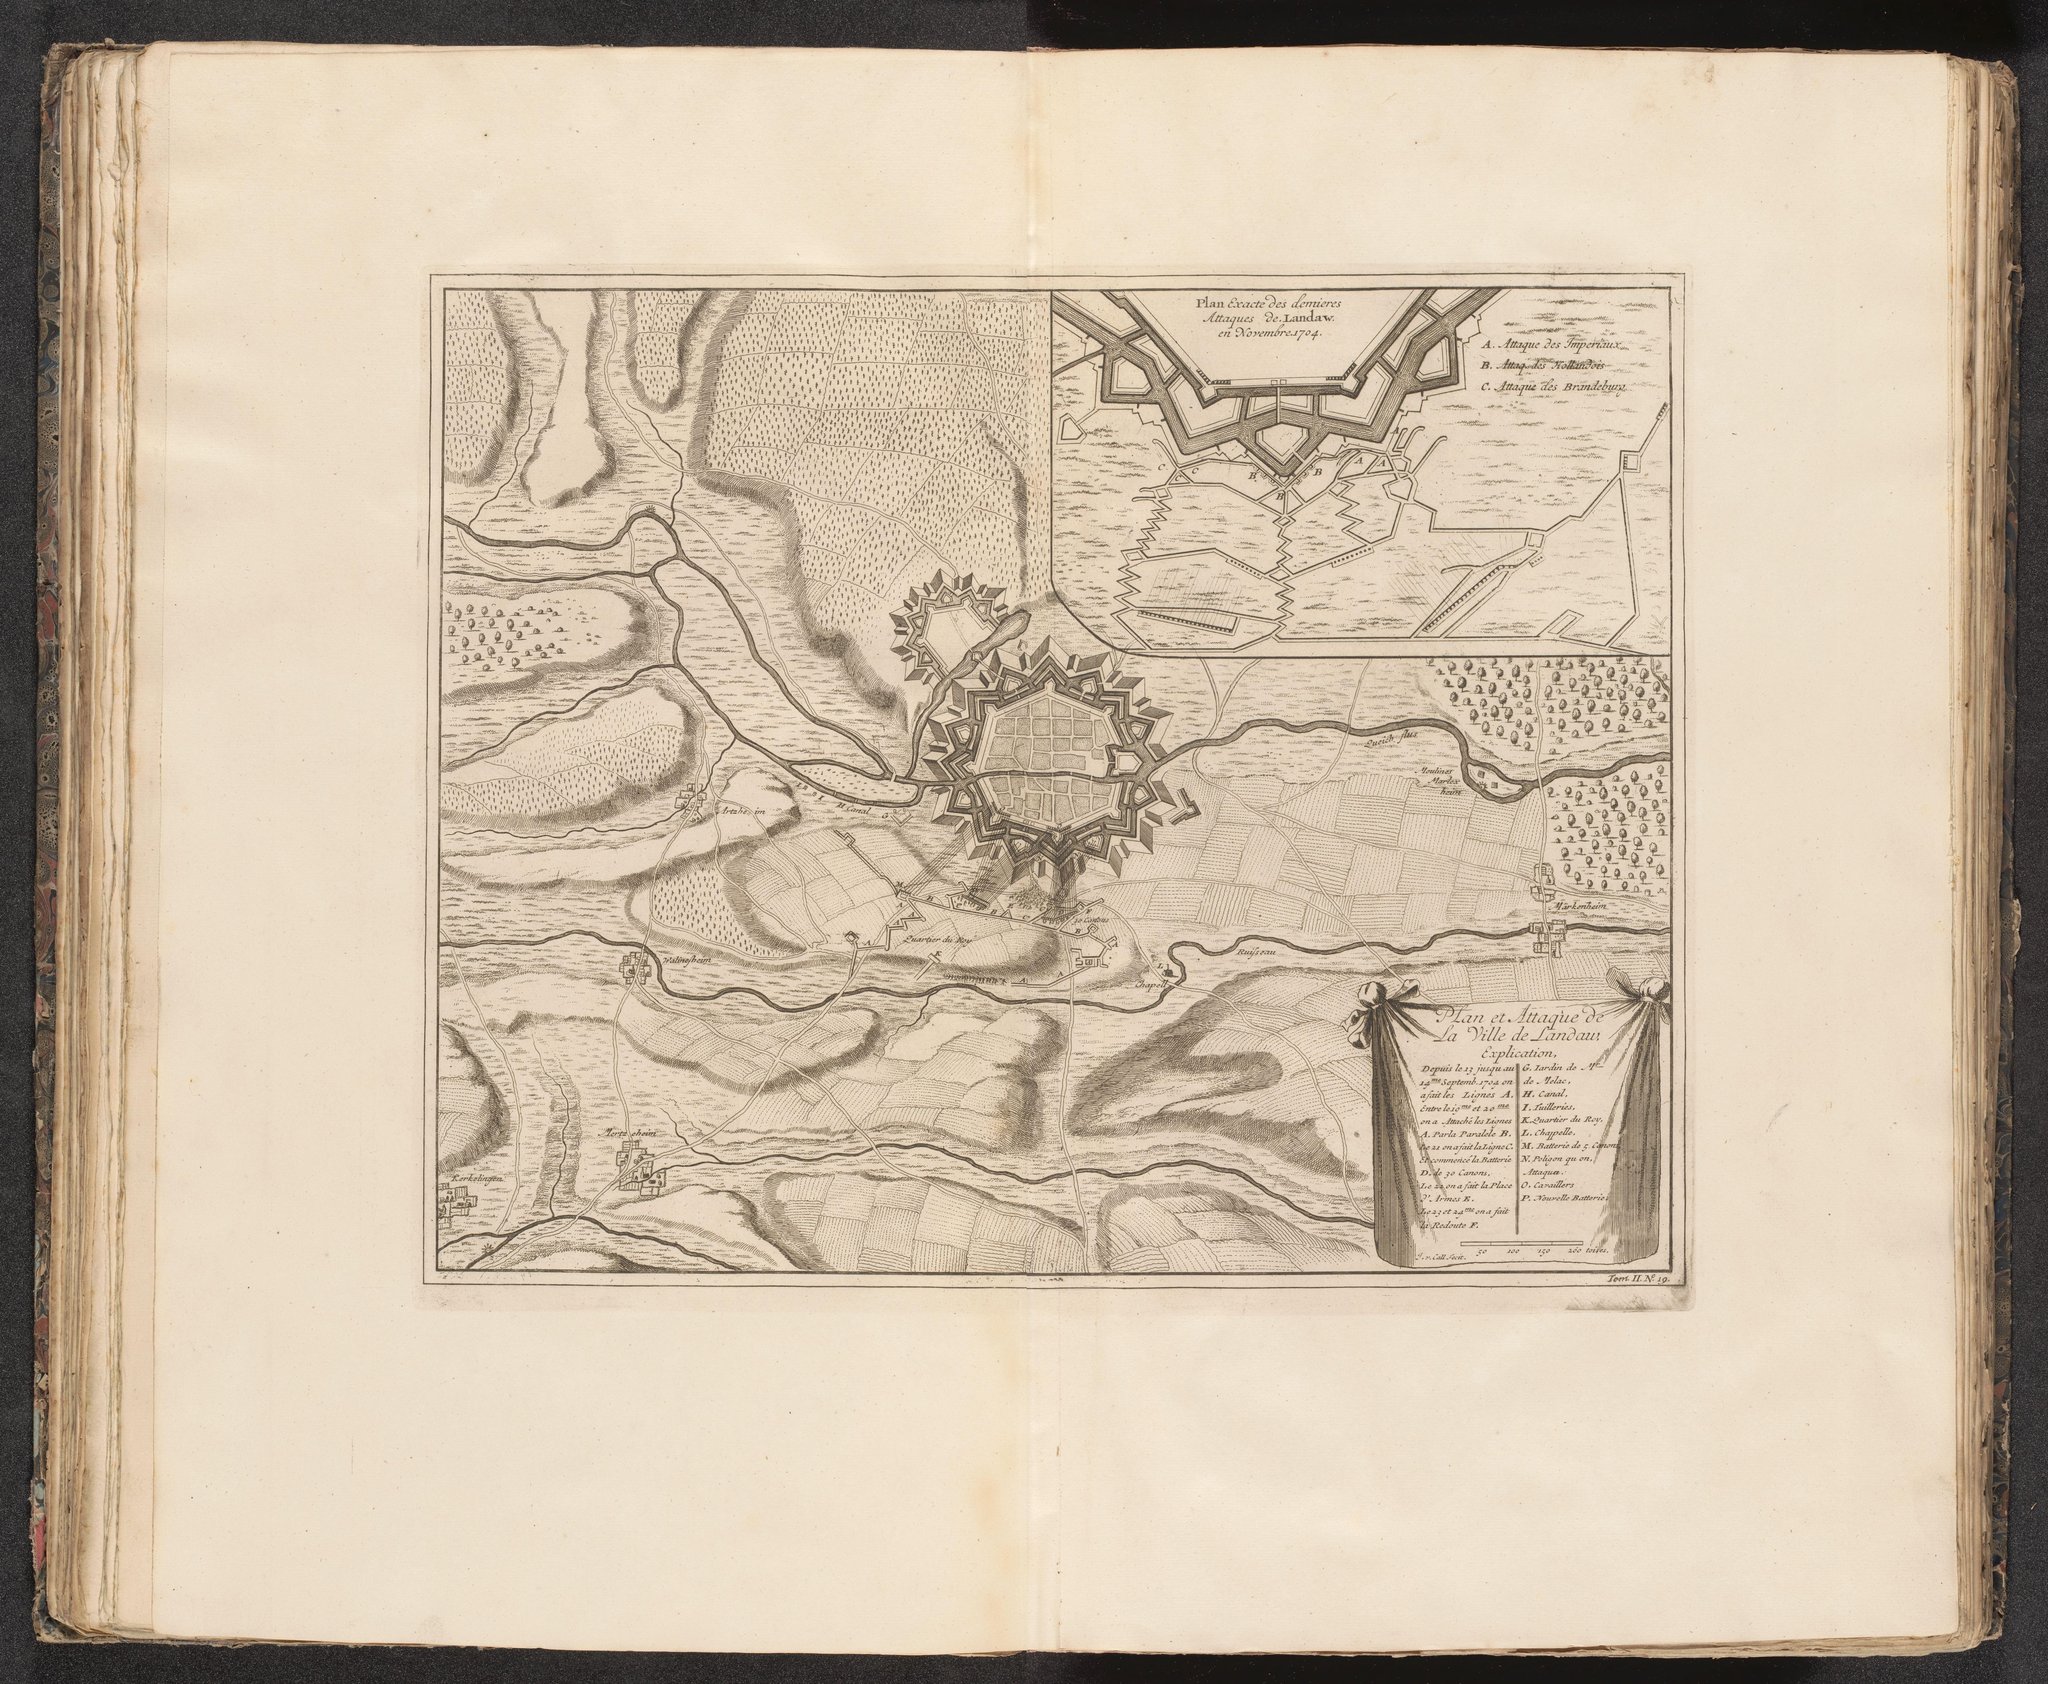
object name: map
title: Plattegrond van Landau, 1704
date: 1704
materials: paper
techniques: etching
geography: northern netherlands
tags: johan willem friso (prins van oranje-nassau), john churchill (1e hertog van marlborough), siege, position war, maps of cities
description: Kaart van het beleg van Landau door de keizerlijke troepen, ingenomen op 25 november 1704. Genummerd rechtsonder: Tom. II. No. 19. Illustratie in het tweede deel van : [Jean] du Mont, Oorlogskundige beschryving van de veldslagen en belegeringen, der drie ... wydvermaarde krygsoversten... den Prins Eugenius van Savoye, den ... Hertog van Marlborough, en den Prins van Oranje en Nassau-Vriesland, in de editie van 1729. Dit tweede deel is hoofdzakelijk gewijd aan de daden van de hertog van Marlborough en prins Johan Willem Friso.